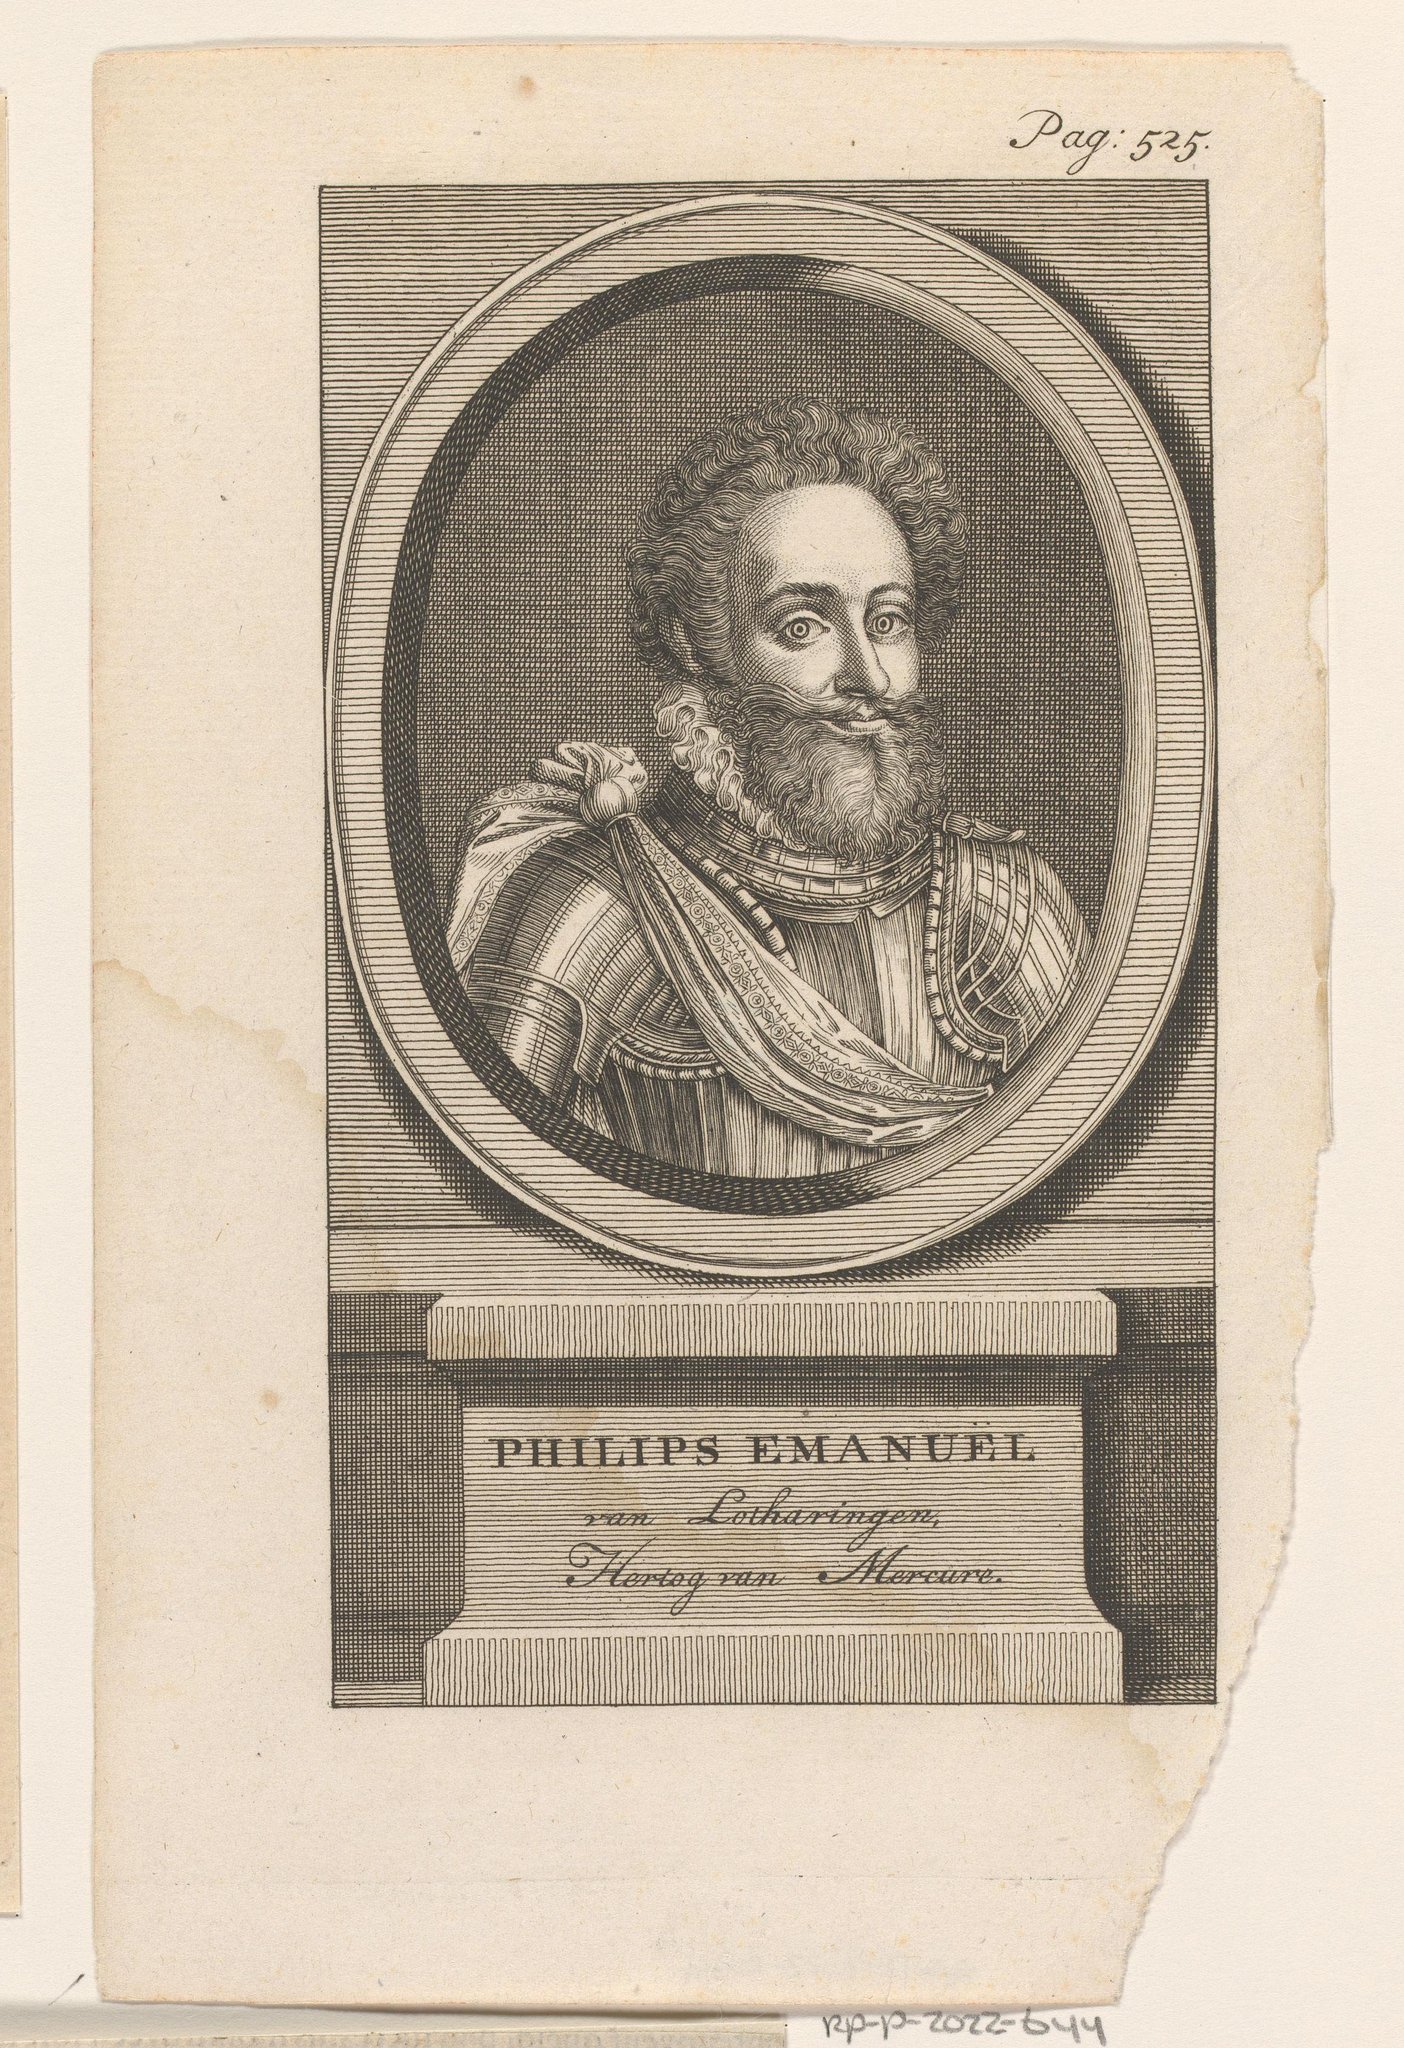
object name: book illustration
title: Portret van Philippe-Emmanuel de Lorraine, hertog van Mercoeur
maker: christian friedrich fritzsch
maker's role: print maker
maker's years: 1719-1774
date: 1753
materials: paper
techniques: engraving, etching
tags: historical persons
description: Prent waarschijnlijk uit: Meteren, Emanuel van. Historie van de oorlogen en geschiedenissen der Nederlanderen, en der zelver Naburen: beginnende met den Jare 1315, en eindigende met den Jare 1611. Amsterdam: Wed. Nicolaas Goetzee, 1753, dl. 6, p. 525.